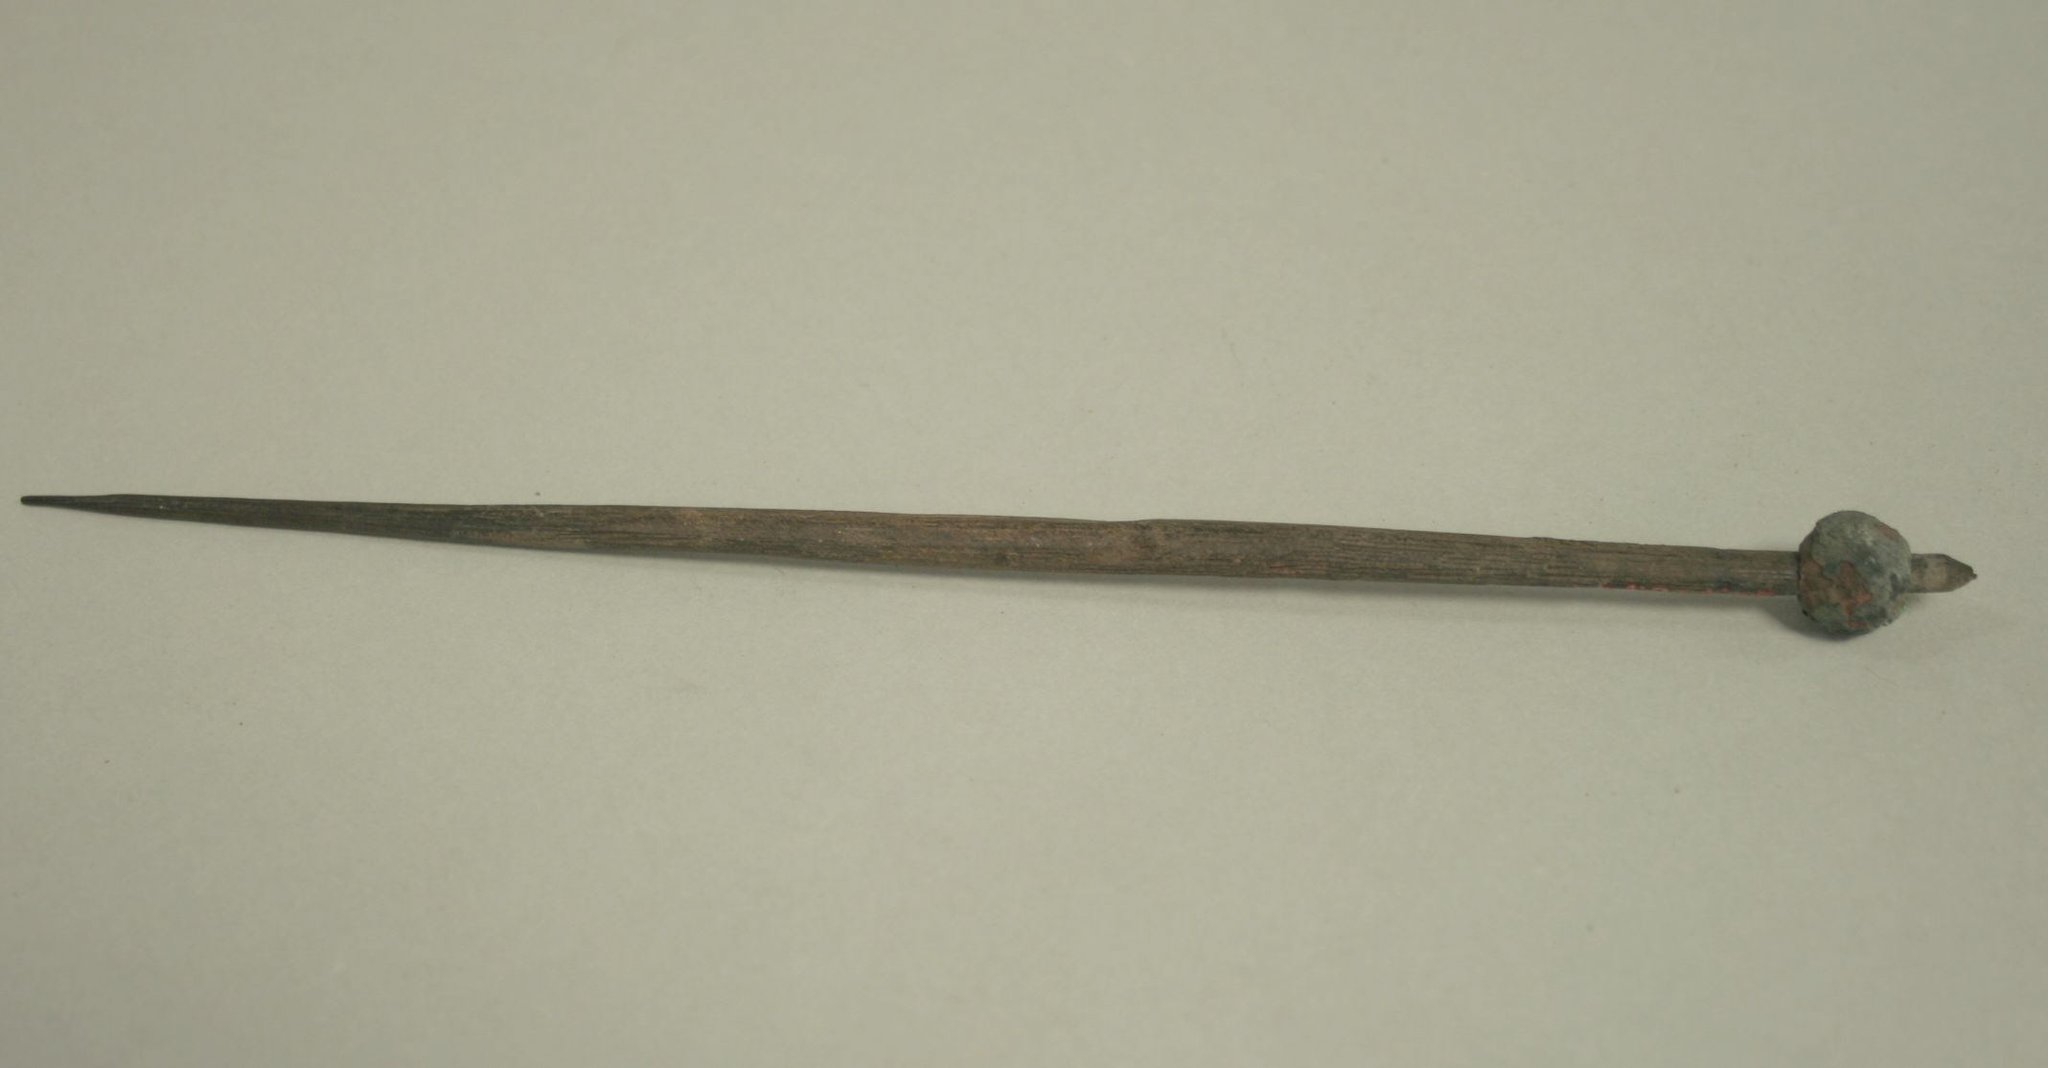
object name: spindle whorl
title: Shell Spindle and Copper Spindle Whorl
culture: peruvian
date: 1501-1600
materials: copper, wood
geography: peru